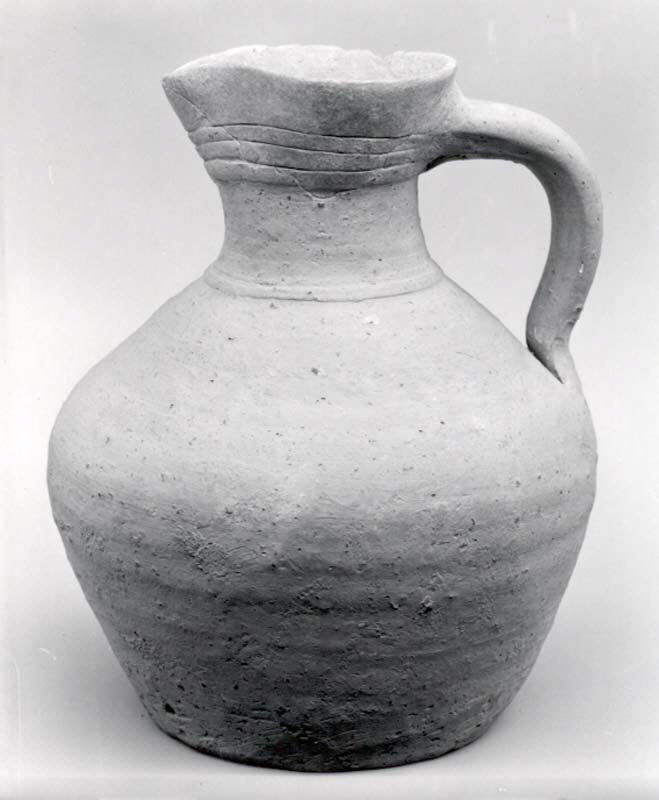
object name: jug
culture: sasanian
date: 201-700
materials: ceramic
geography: iran